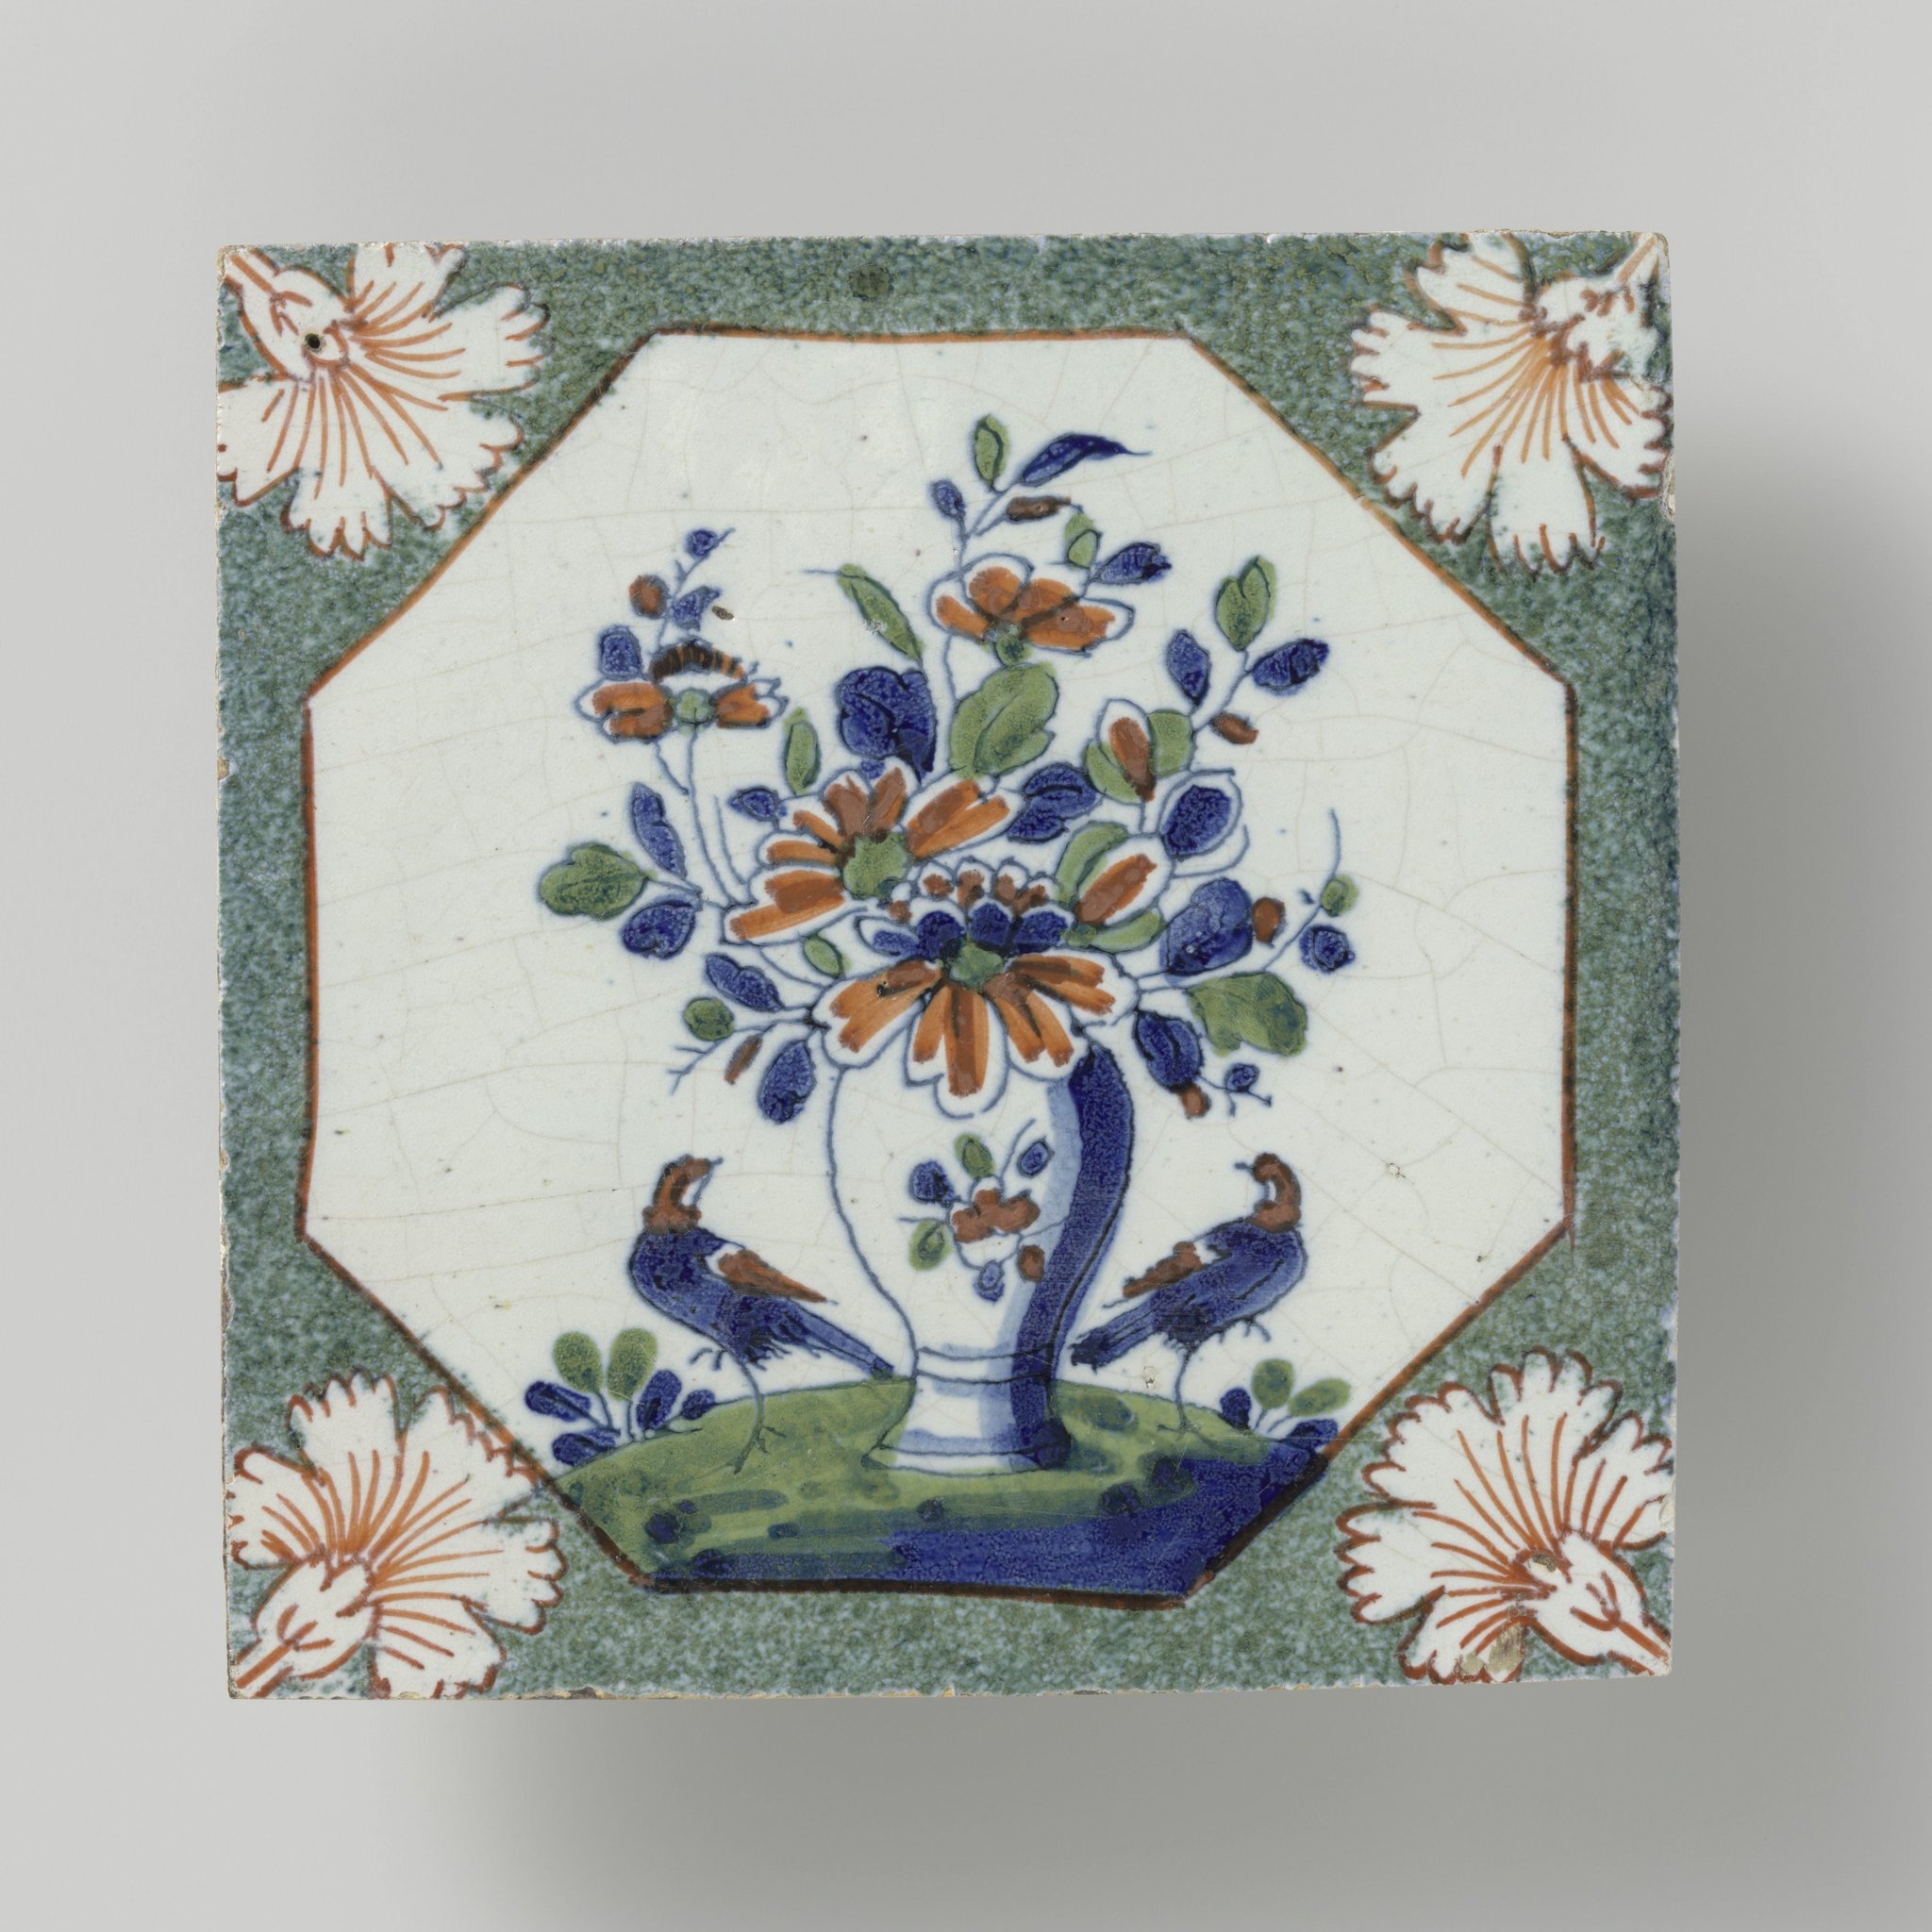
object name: tile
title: Tegel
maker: Anonymous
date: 1720-1760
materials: earthenware, glaze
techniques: maiolica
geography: england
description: Tegel met een veelkleurige (blauw, rood en groen) vaas met bloemen met aan weerszijden een vogel omlijst door een achtkant uitgespaard in groen. In de hoeken, een anjer.